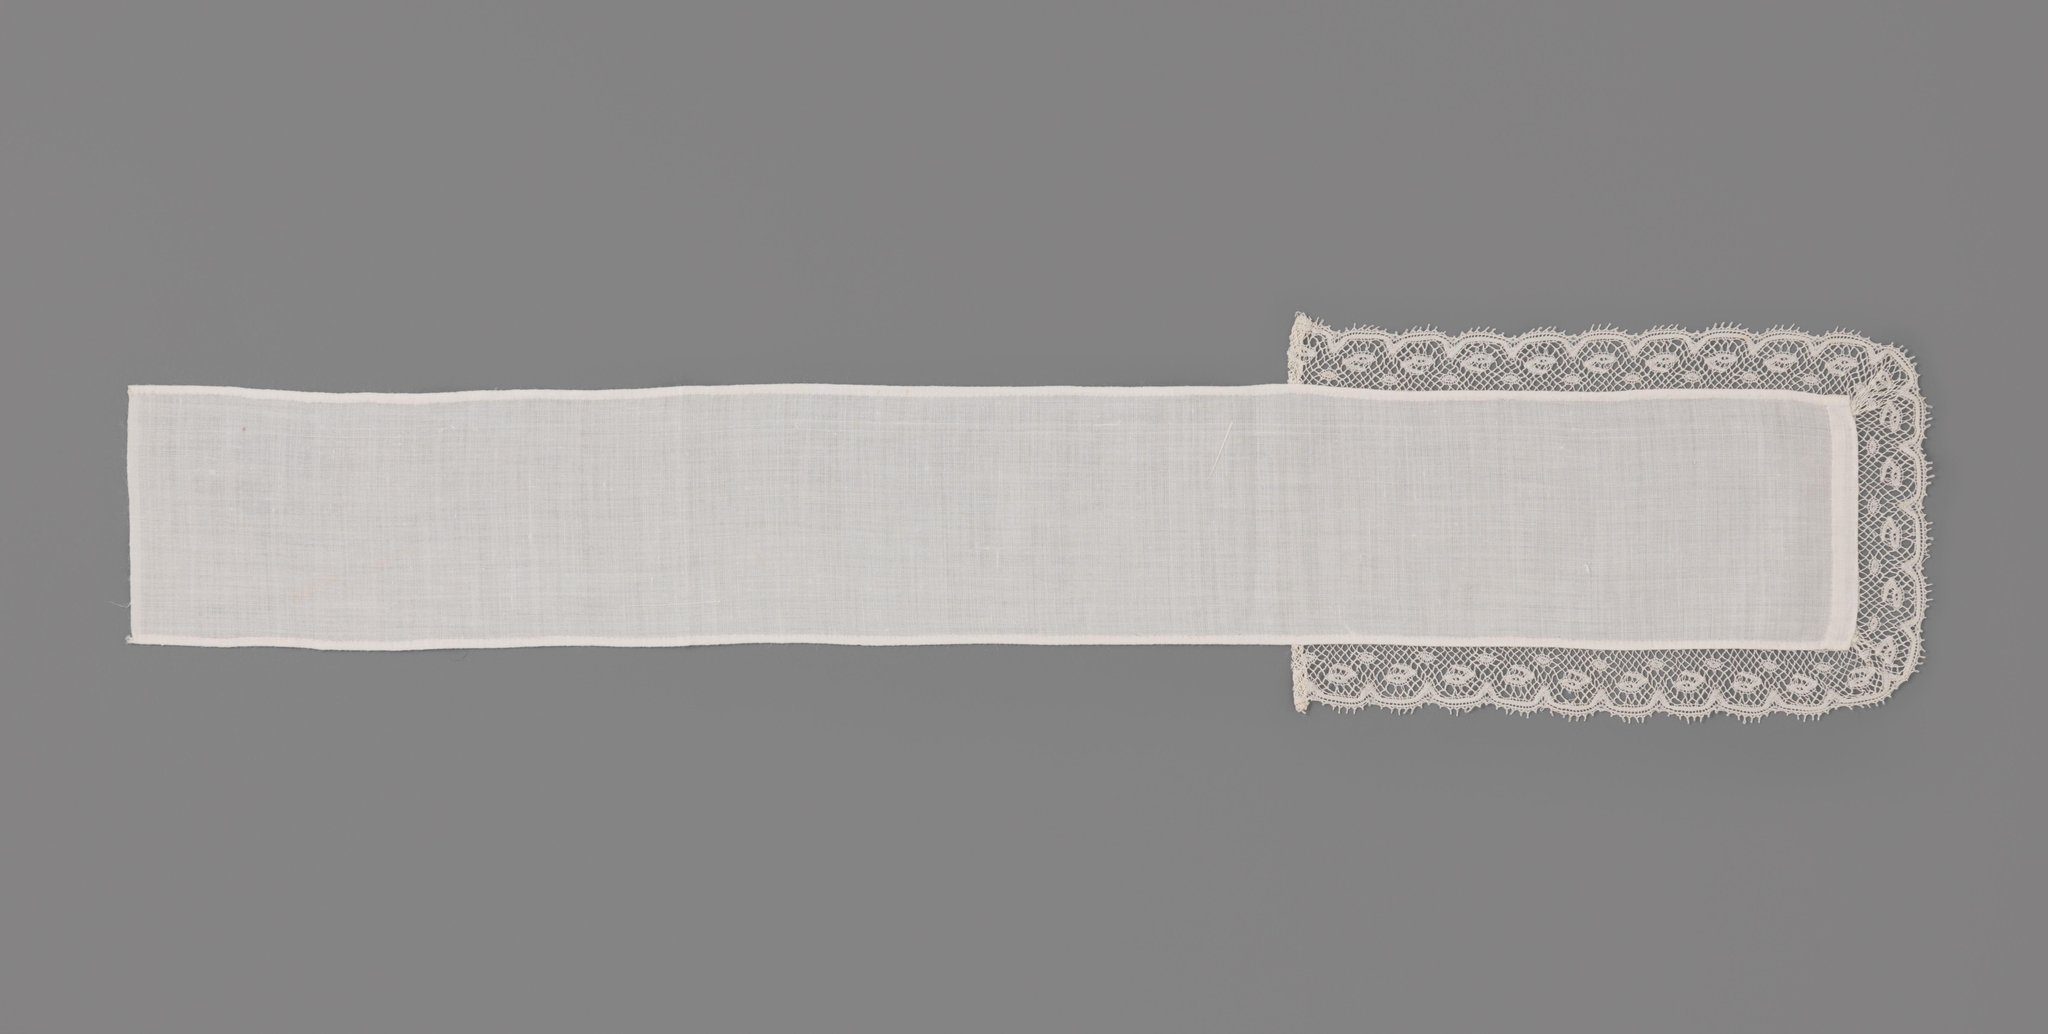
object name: strikdas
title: Strikdas, rechthoekig, van linnenbatist met glad aangezette geschulpte en gepicoteerde strook Valenciennes-kant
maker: Anonymous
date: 1880-1890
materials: linen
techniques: lace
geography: netherlands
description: Strikdas, rechthoekig, van linnenbatist met glad aangezette geschulpte en gepicoteerde strook Valenciennes-kant.